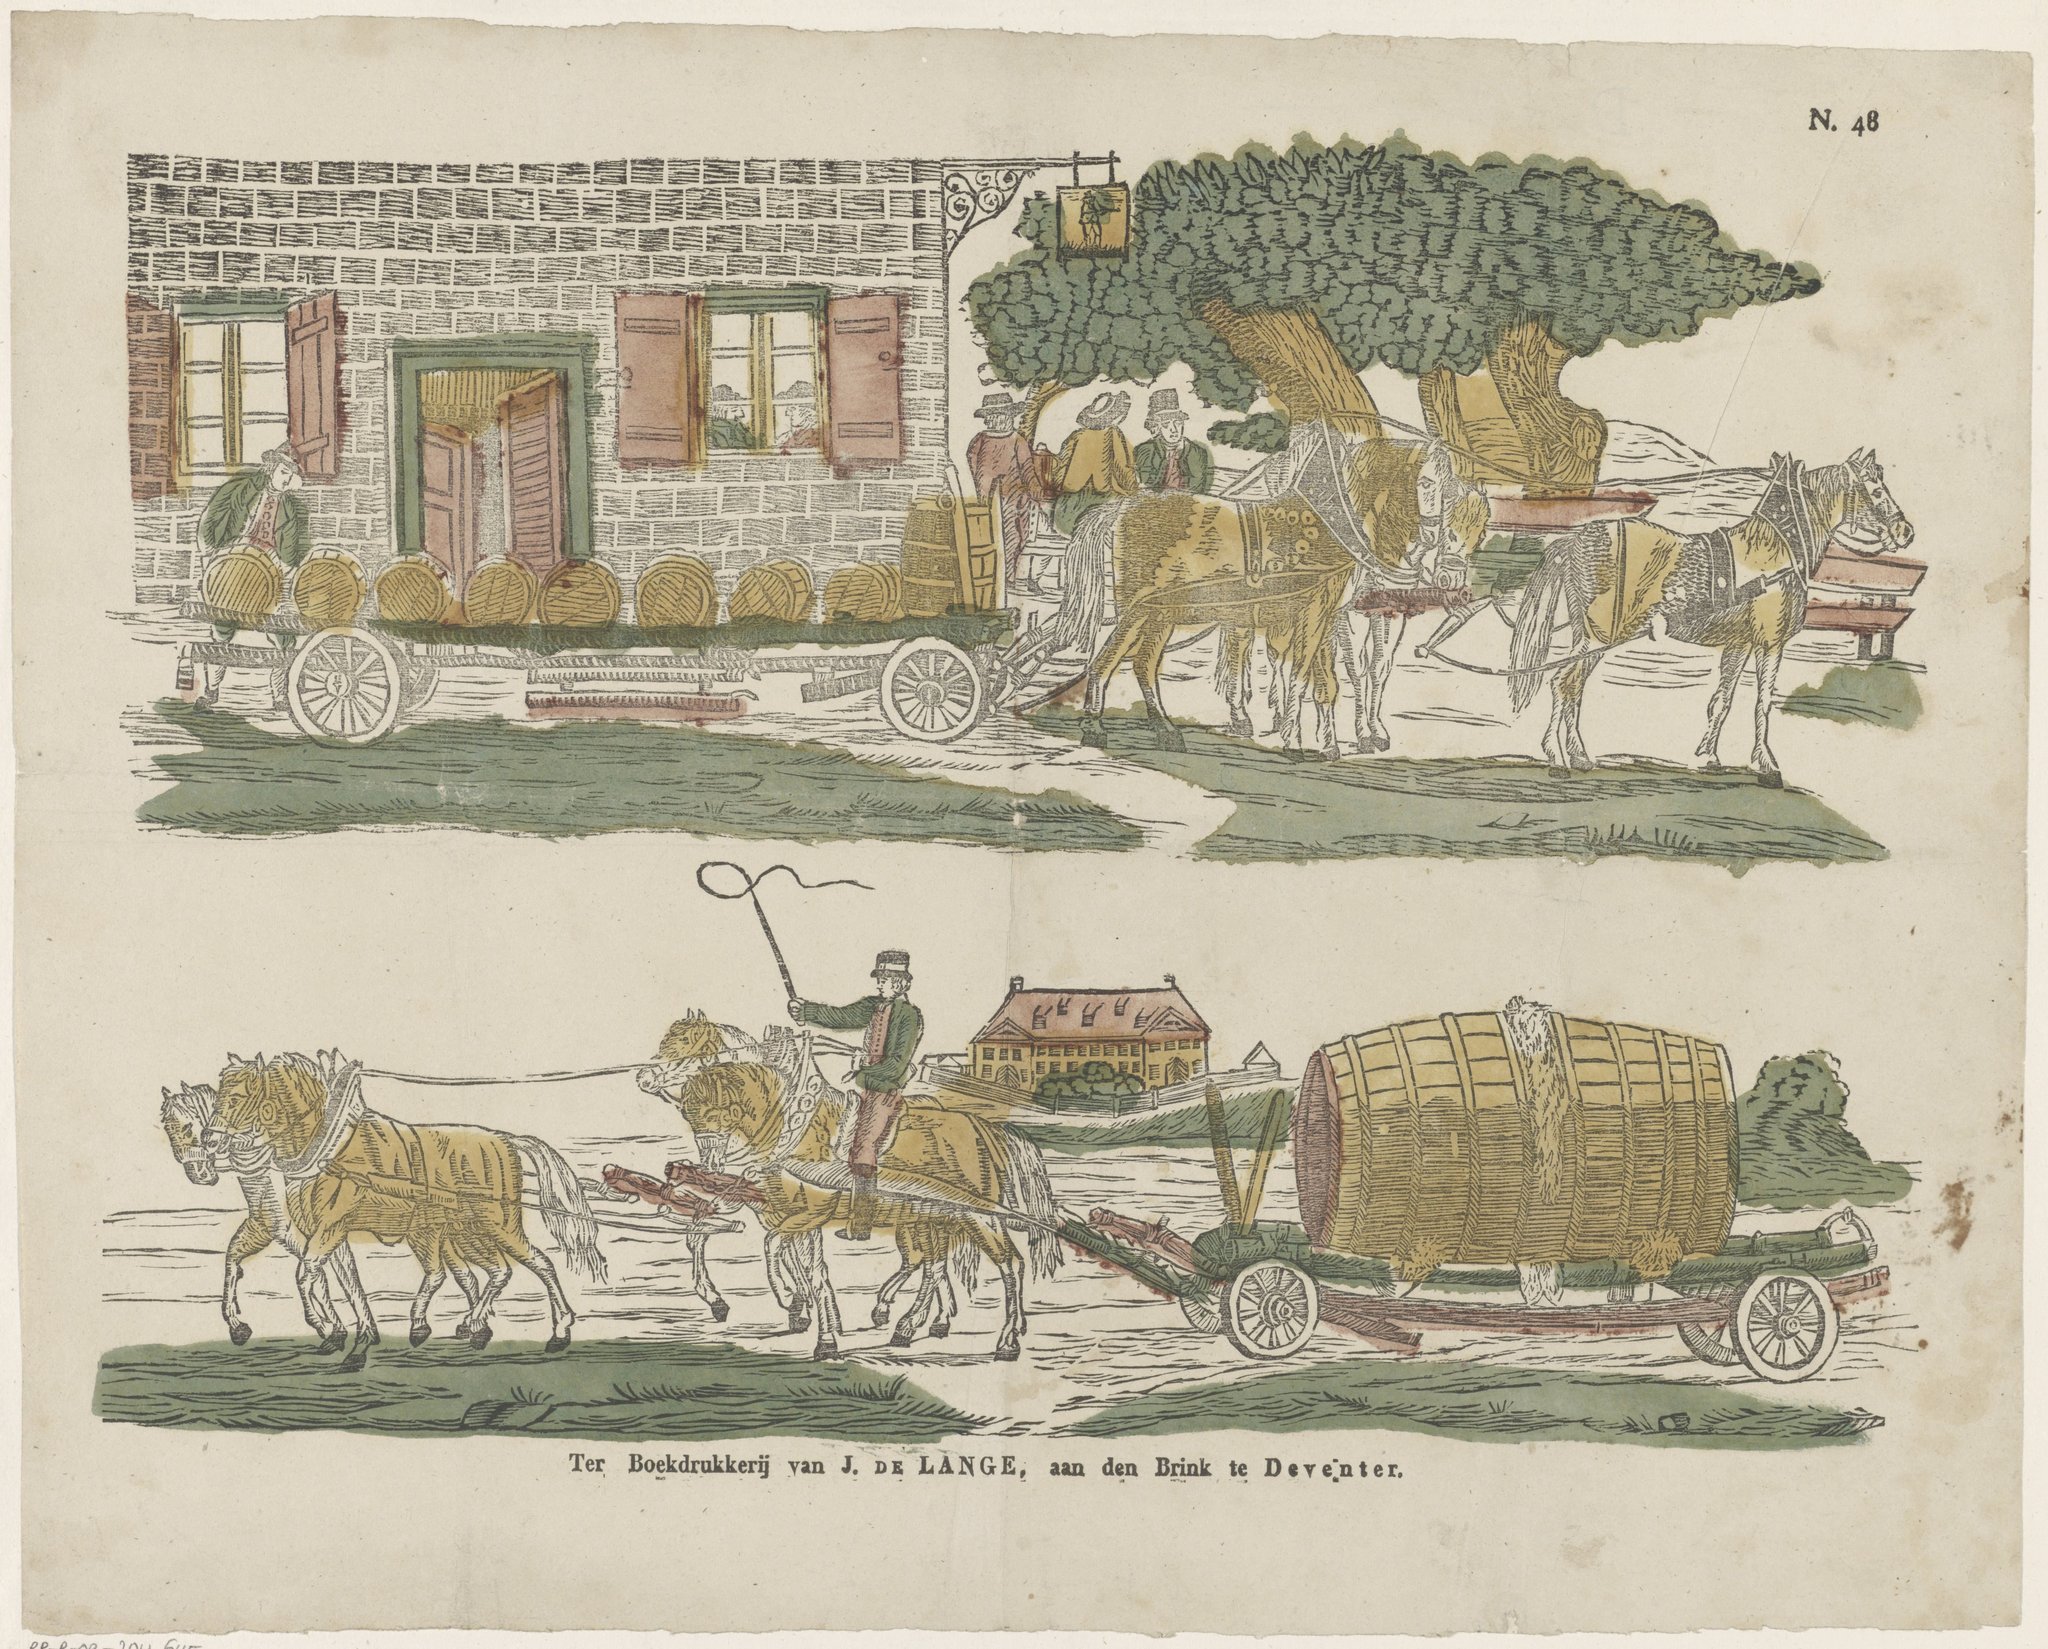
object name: popular print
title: Bierwagens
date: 1822-1849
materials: paper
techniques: colour, letterpress printing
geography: deventer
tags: traffic and transport, beer, ale (+ foodstuffs in other container, e.g.: barrel, can, cask, tin, etc.), hotel, hostelry, inn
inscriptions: collector's mark: Lugt 2760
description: Blad met 2 voorstellingen van bierwagens. Genummerd rechtsboven: N. 48.